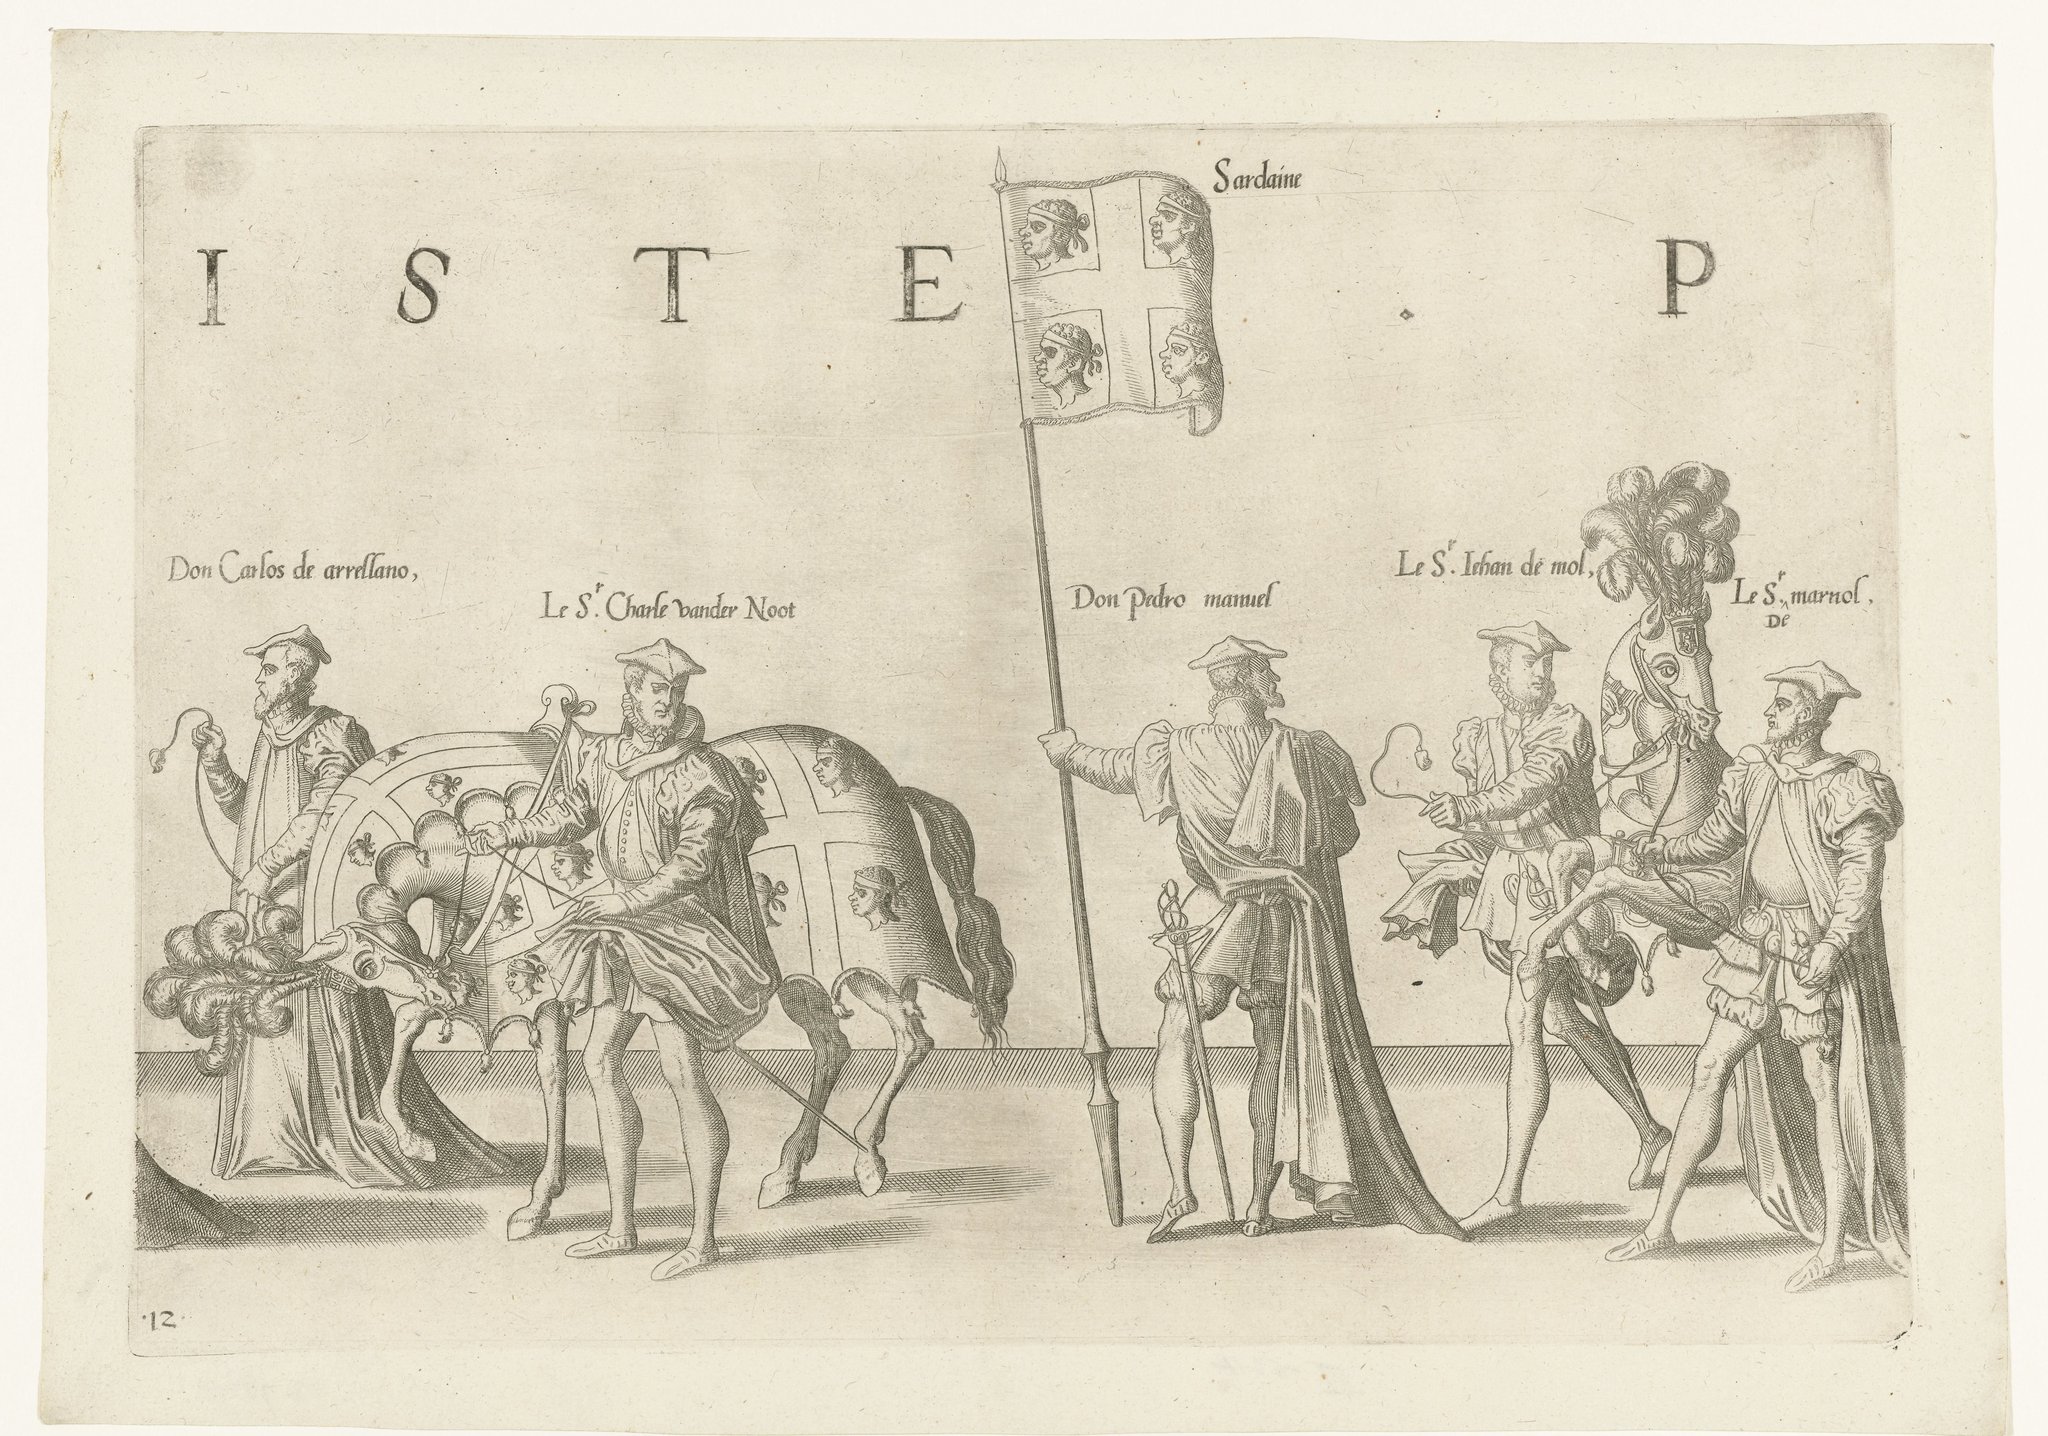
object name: print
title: Deel van de optocht, nr. 12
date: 1559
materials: paper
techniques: engraving, etching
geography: southern netherlands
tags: ghent, charles v (holy roman emperor and king of spain), cortege, funeral procession, brussels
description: Vijf deelnemers aan de optocht, paarden en het vaandel met het wapen van Sardinië. Onderdeel van de prentreeks van de Begrafenisoptocht van keizer Karel V op 29 december 1558 te Brussel.